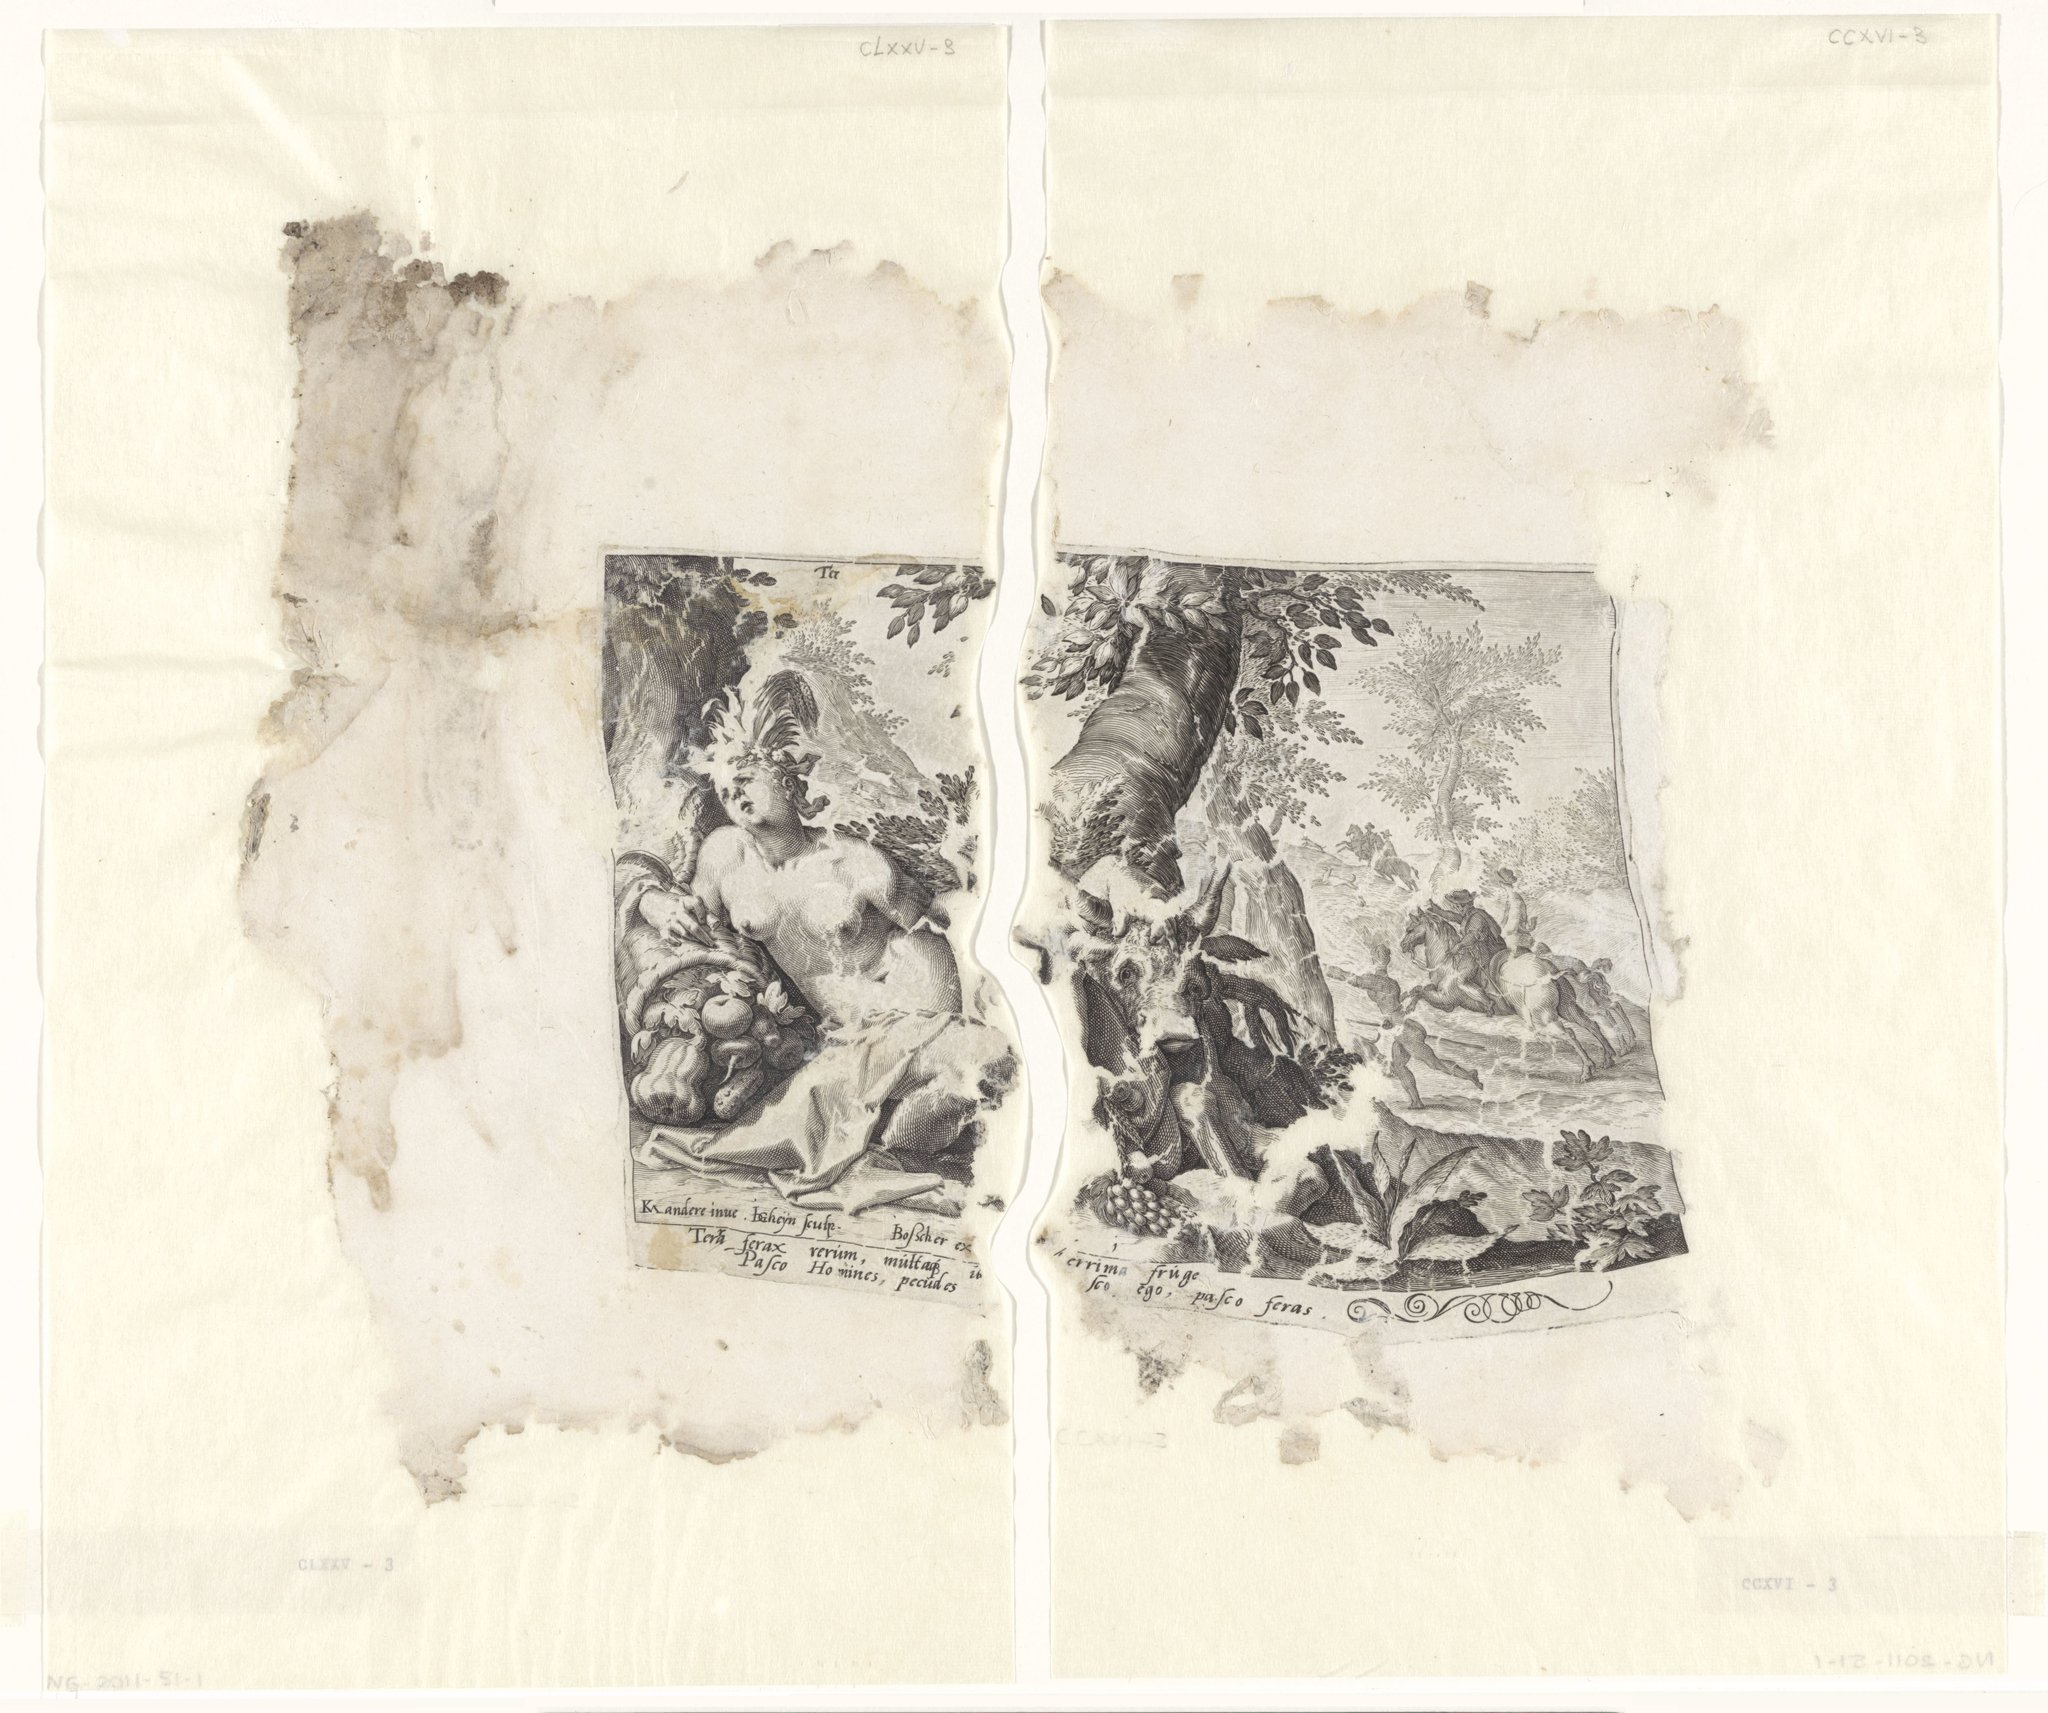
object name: print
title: Aarde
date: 1580-1596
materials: paper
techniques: engraving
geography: amsterdam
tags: earth (one of the four elements)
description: De prenten in de Nova Zembla collectie zijn tijdens een expeditie van Willem Barendsz en Jacob van Heemskerk in 1596-1597 noodgedwongen in het winterkamp, het ‘Behouden Huis’, op het eiland achtergelaten. De prenten waren in één of meerdere stapels als handelswaar meegenomen vanuit Amsterdam. Bijna drie eeuwen later, in 1871, keerde de Noor Elling Carlsen terug naar Nova Zembla en vond daar de restanten van het ‘Behouden Huis, inclusief een groot deel van de inventaris. Een deel van de prenten, in de vorm van aaneengekoekte kluiten, werd toen ook teruggevonden. De papierkluiten waren soms op meerdere plekken gebroken. Tussen 1975-1979 zijn de prenten van elkaar gescheiden. Dit leverde in totaal ca. 1000 fragmenten van ca. 400 afdrukken van ca. 150 verschillende prenten op. Voor zover mogelijk zijn de fragmenten samengevoegd en zijn de prenten gereconstrueerd.